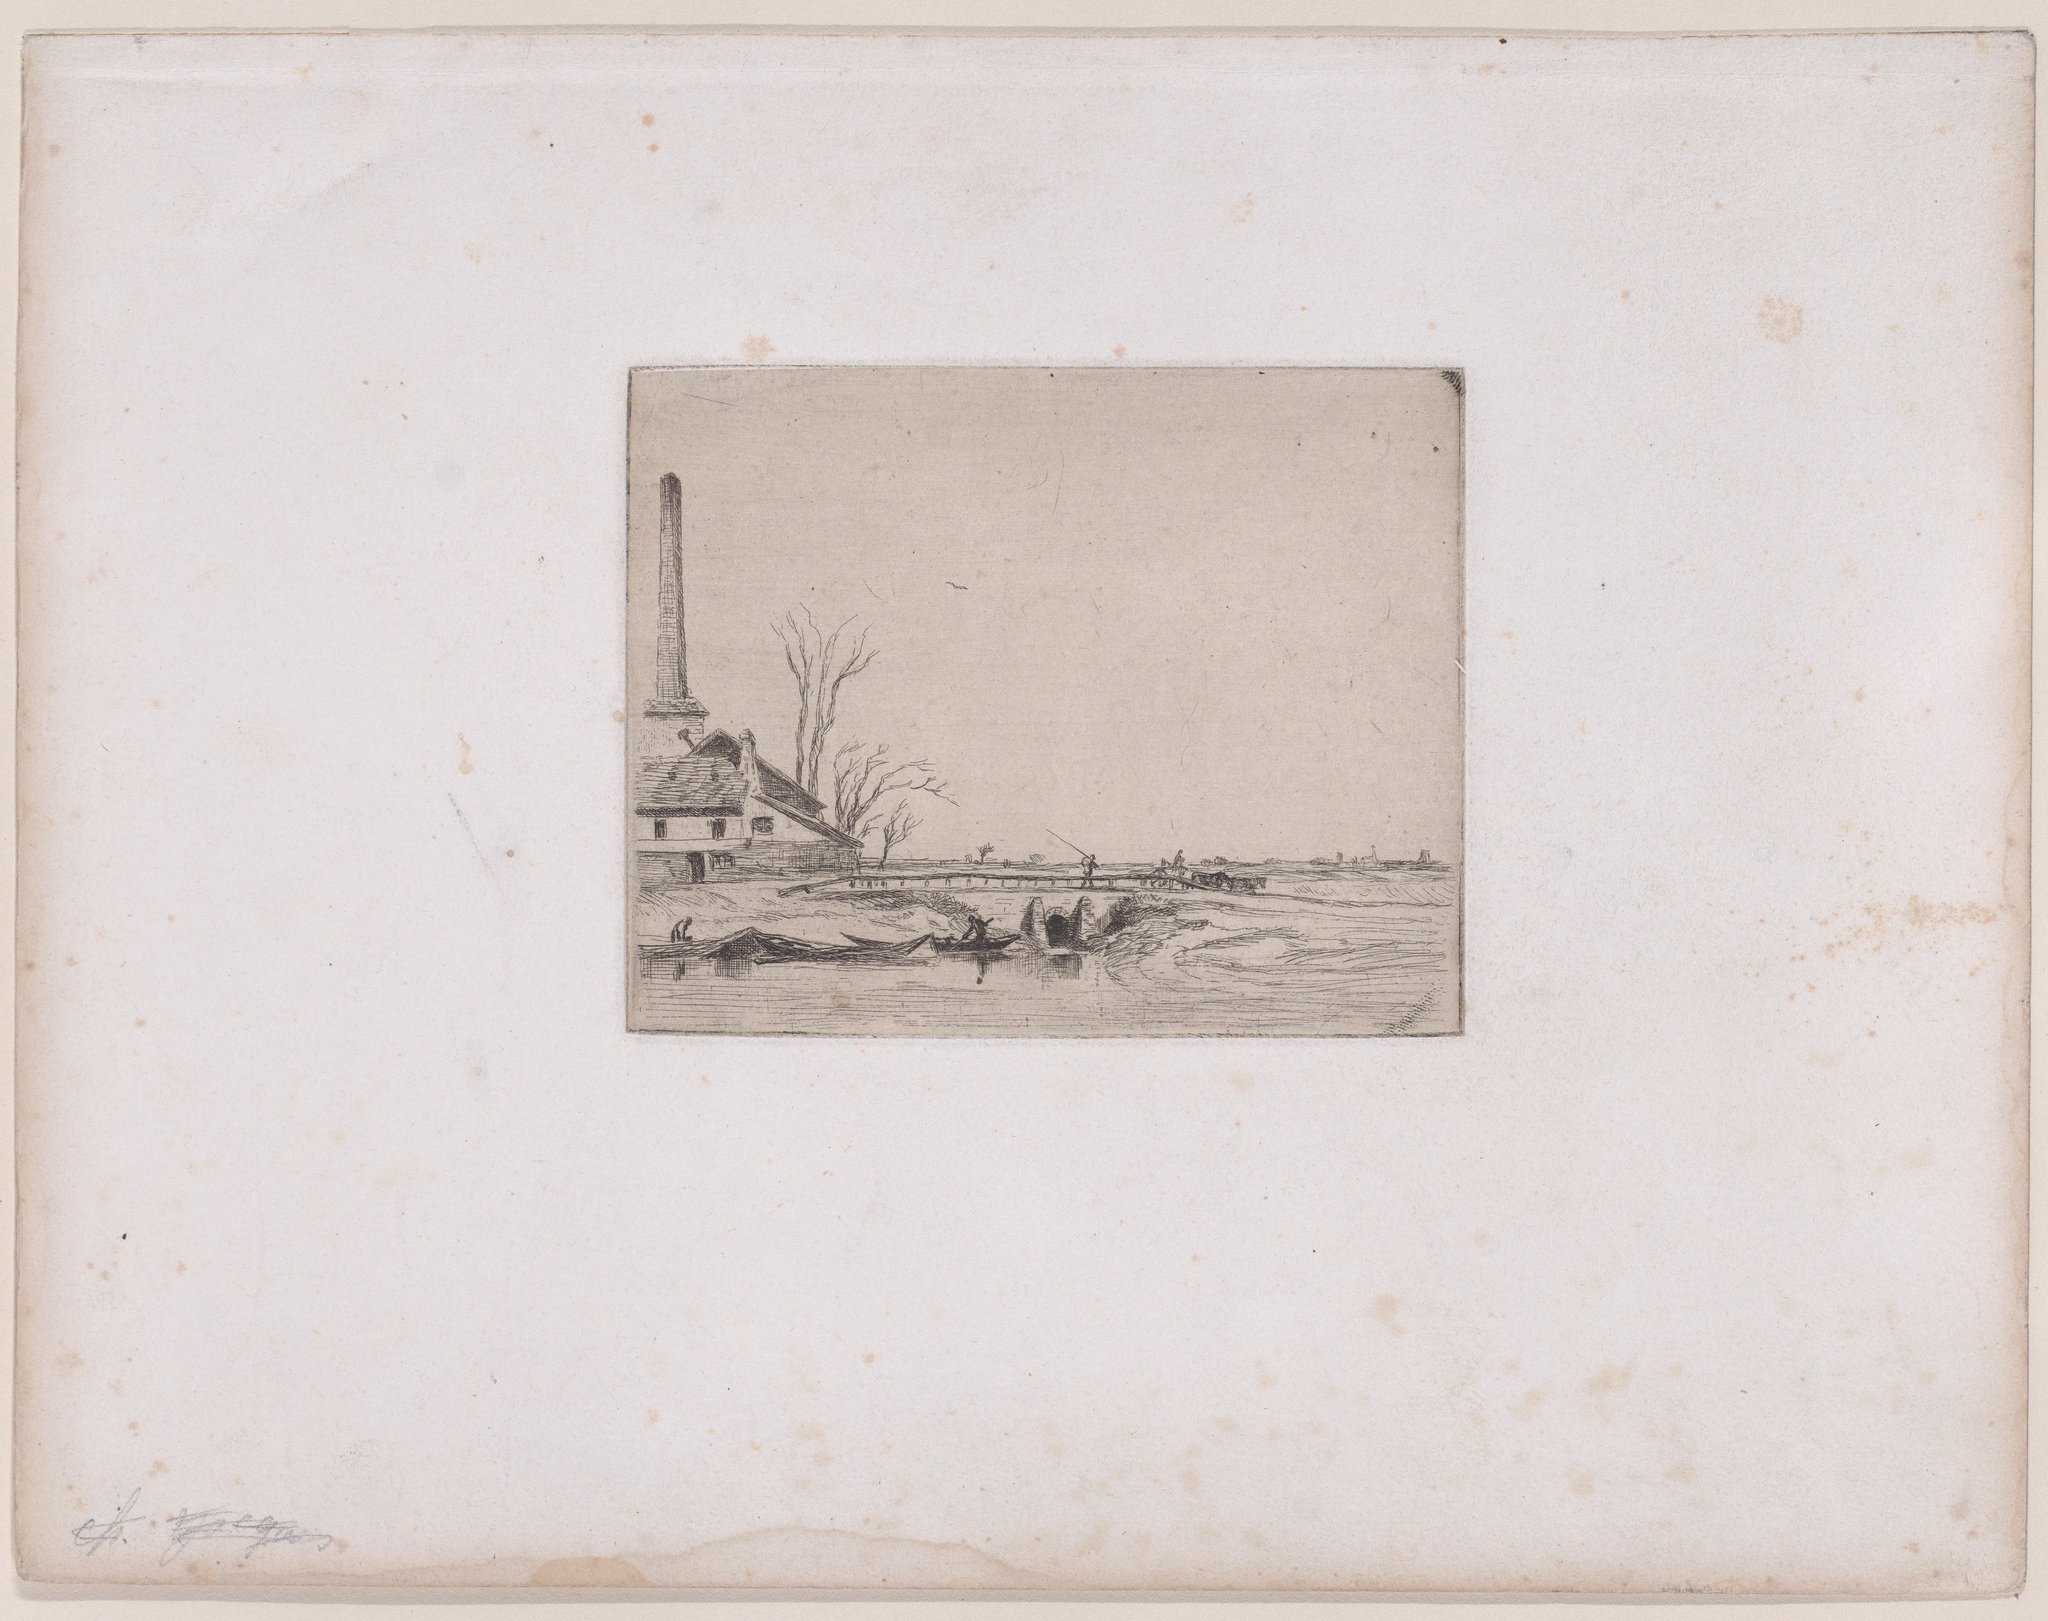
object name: print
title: Study of an Old Man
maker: charles émile jacque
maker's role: artist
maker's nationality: french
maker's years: 1813-1894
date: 1859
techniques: etching